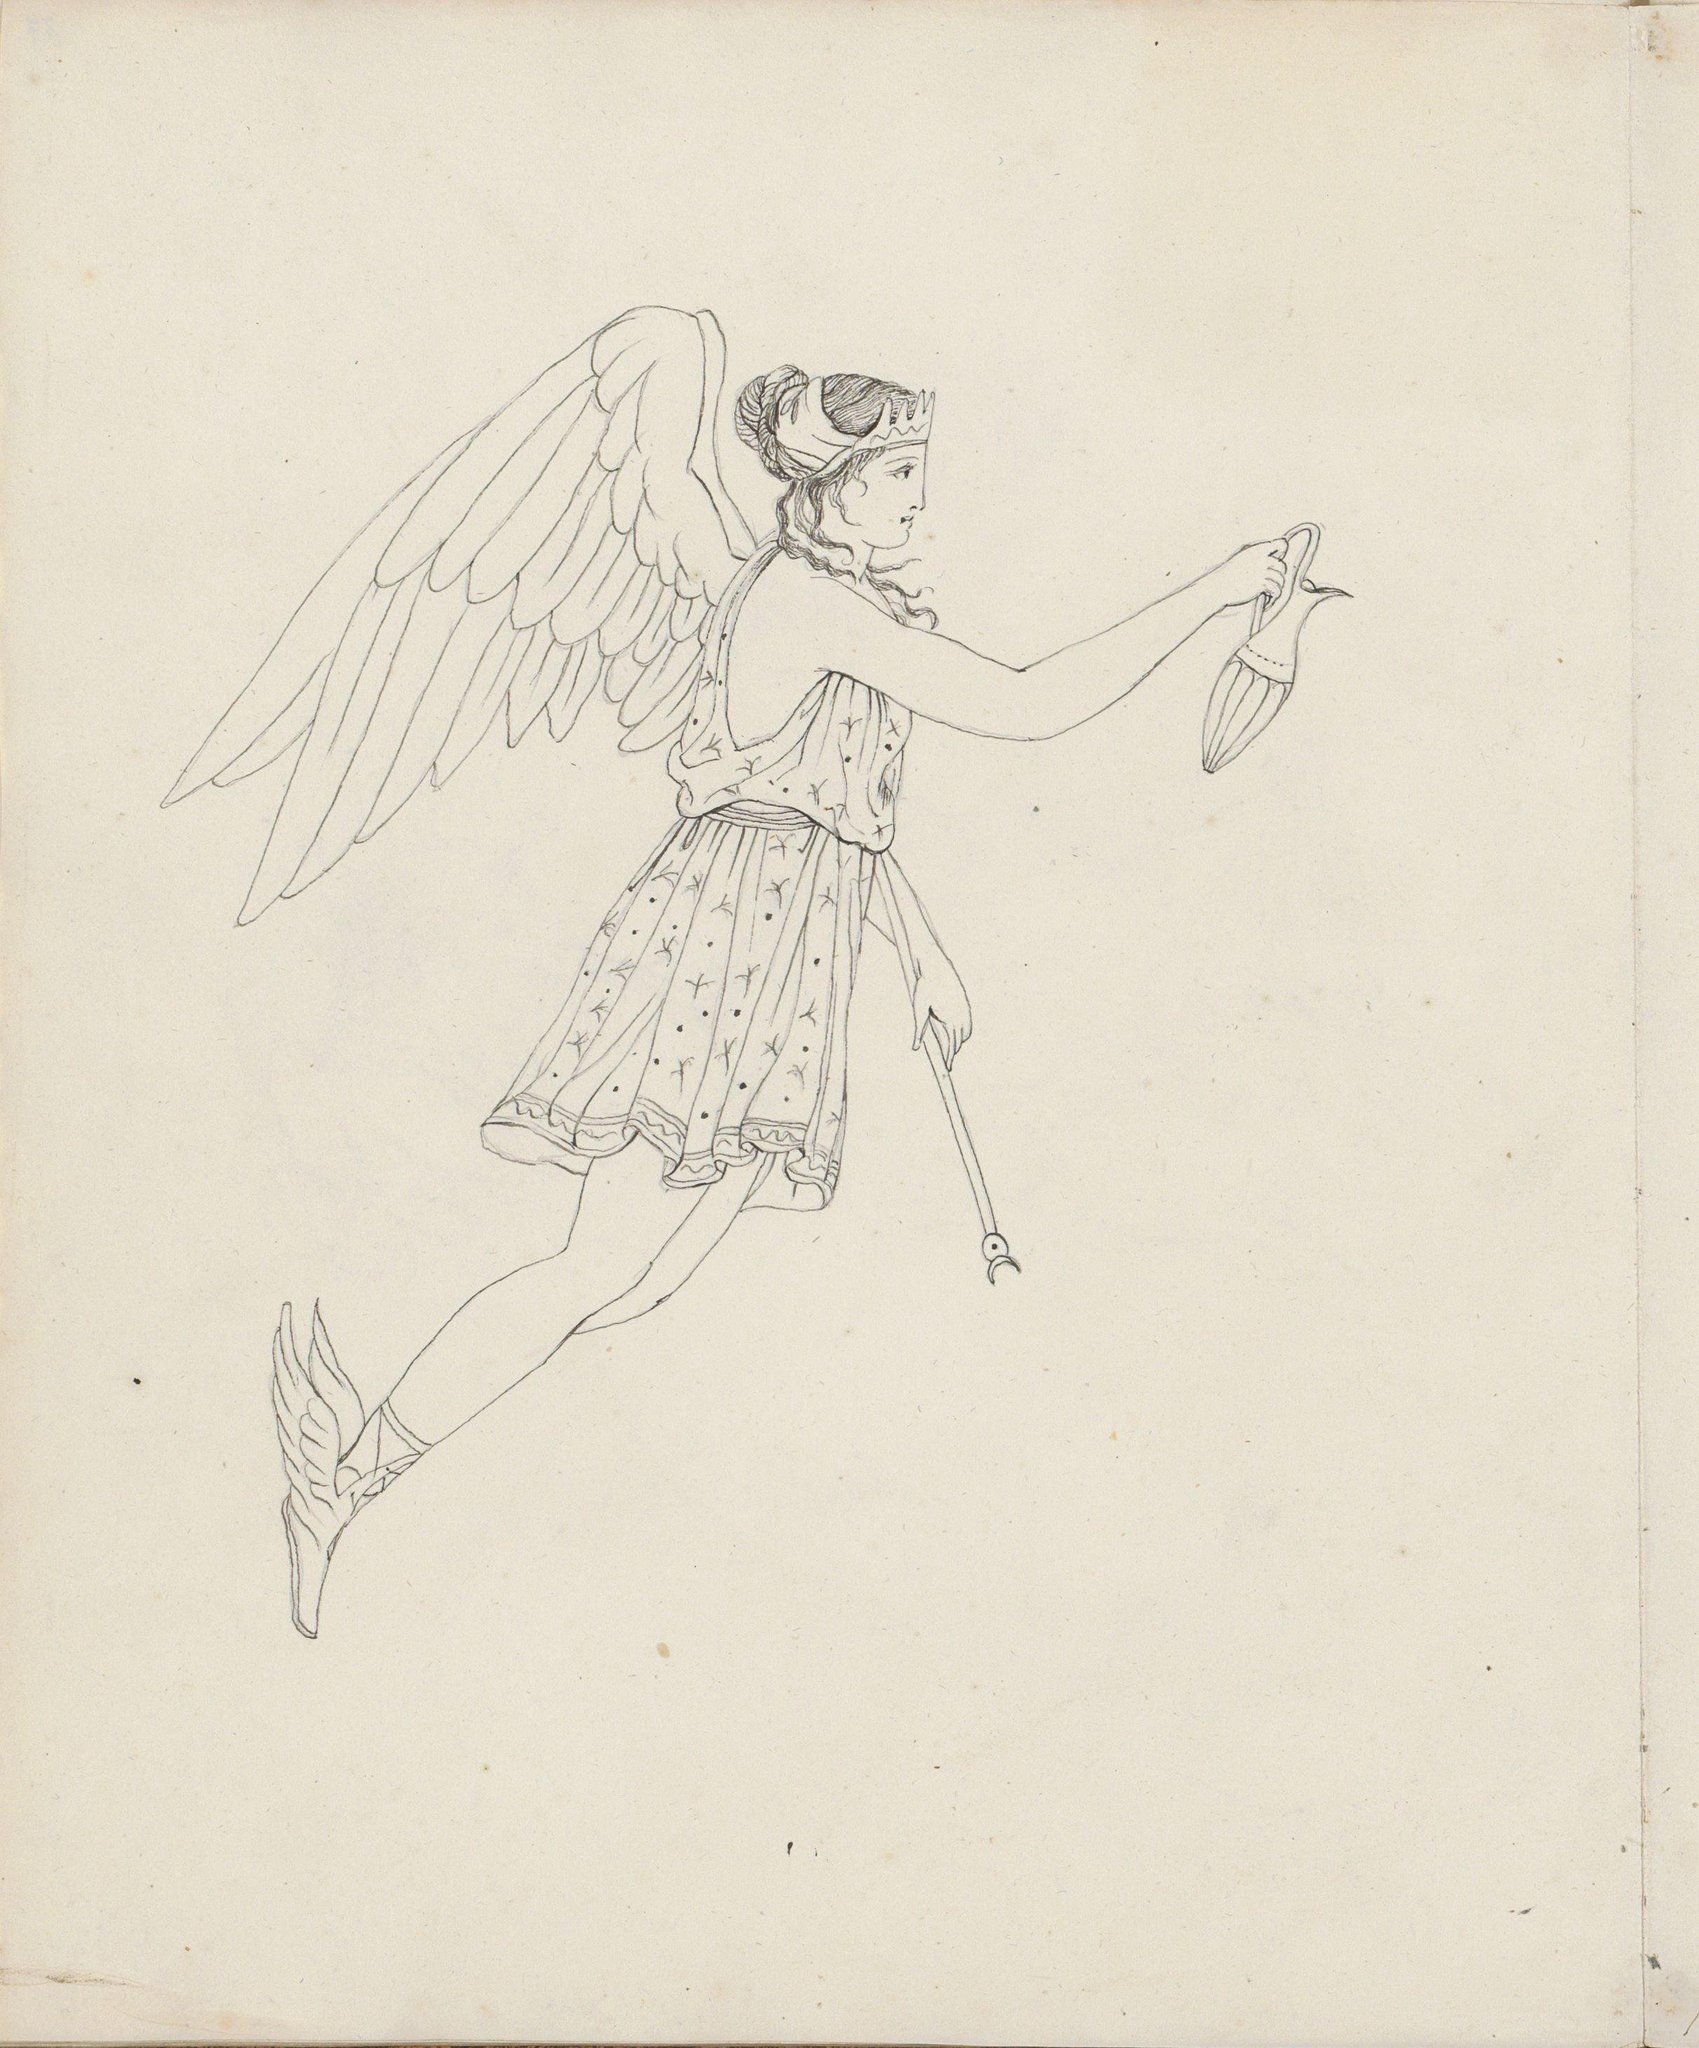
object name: sketchbook leaf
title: Gevleugelde vrouw met een kroon en een kan in de hand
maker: jonkvrouw elisabeth kemper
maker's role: draughtsman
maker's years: 1799-1871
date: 1815-1852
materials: ink, paper, pencil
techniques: pen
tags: abstract ideas and concepts (+ clothed), container of ceramics: jar, jug, pot, vase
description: De vrouw, mogelijk Iris, de boodschapper van de goden, heeft vleugels aan haar sandalen, draagt een korte tuniek en heeft een staf in haar hand. Vermoedelijk getekend naar een klassiek voorbeeld. Blad 37 verso uit een schetsboek met 94 bladen.